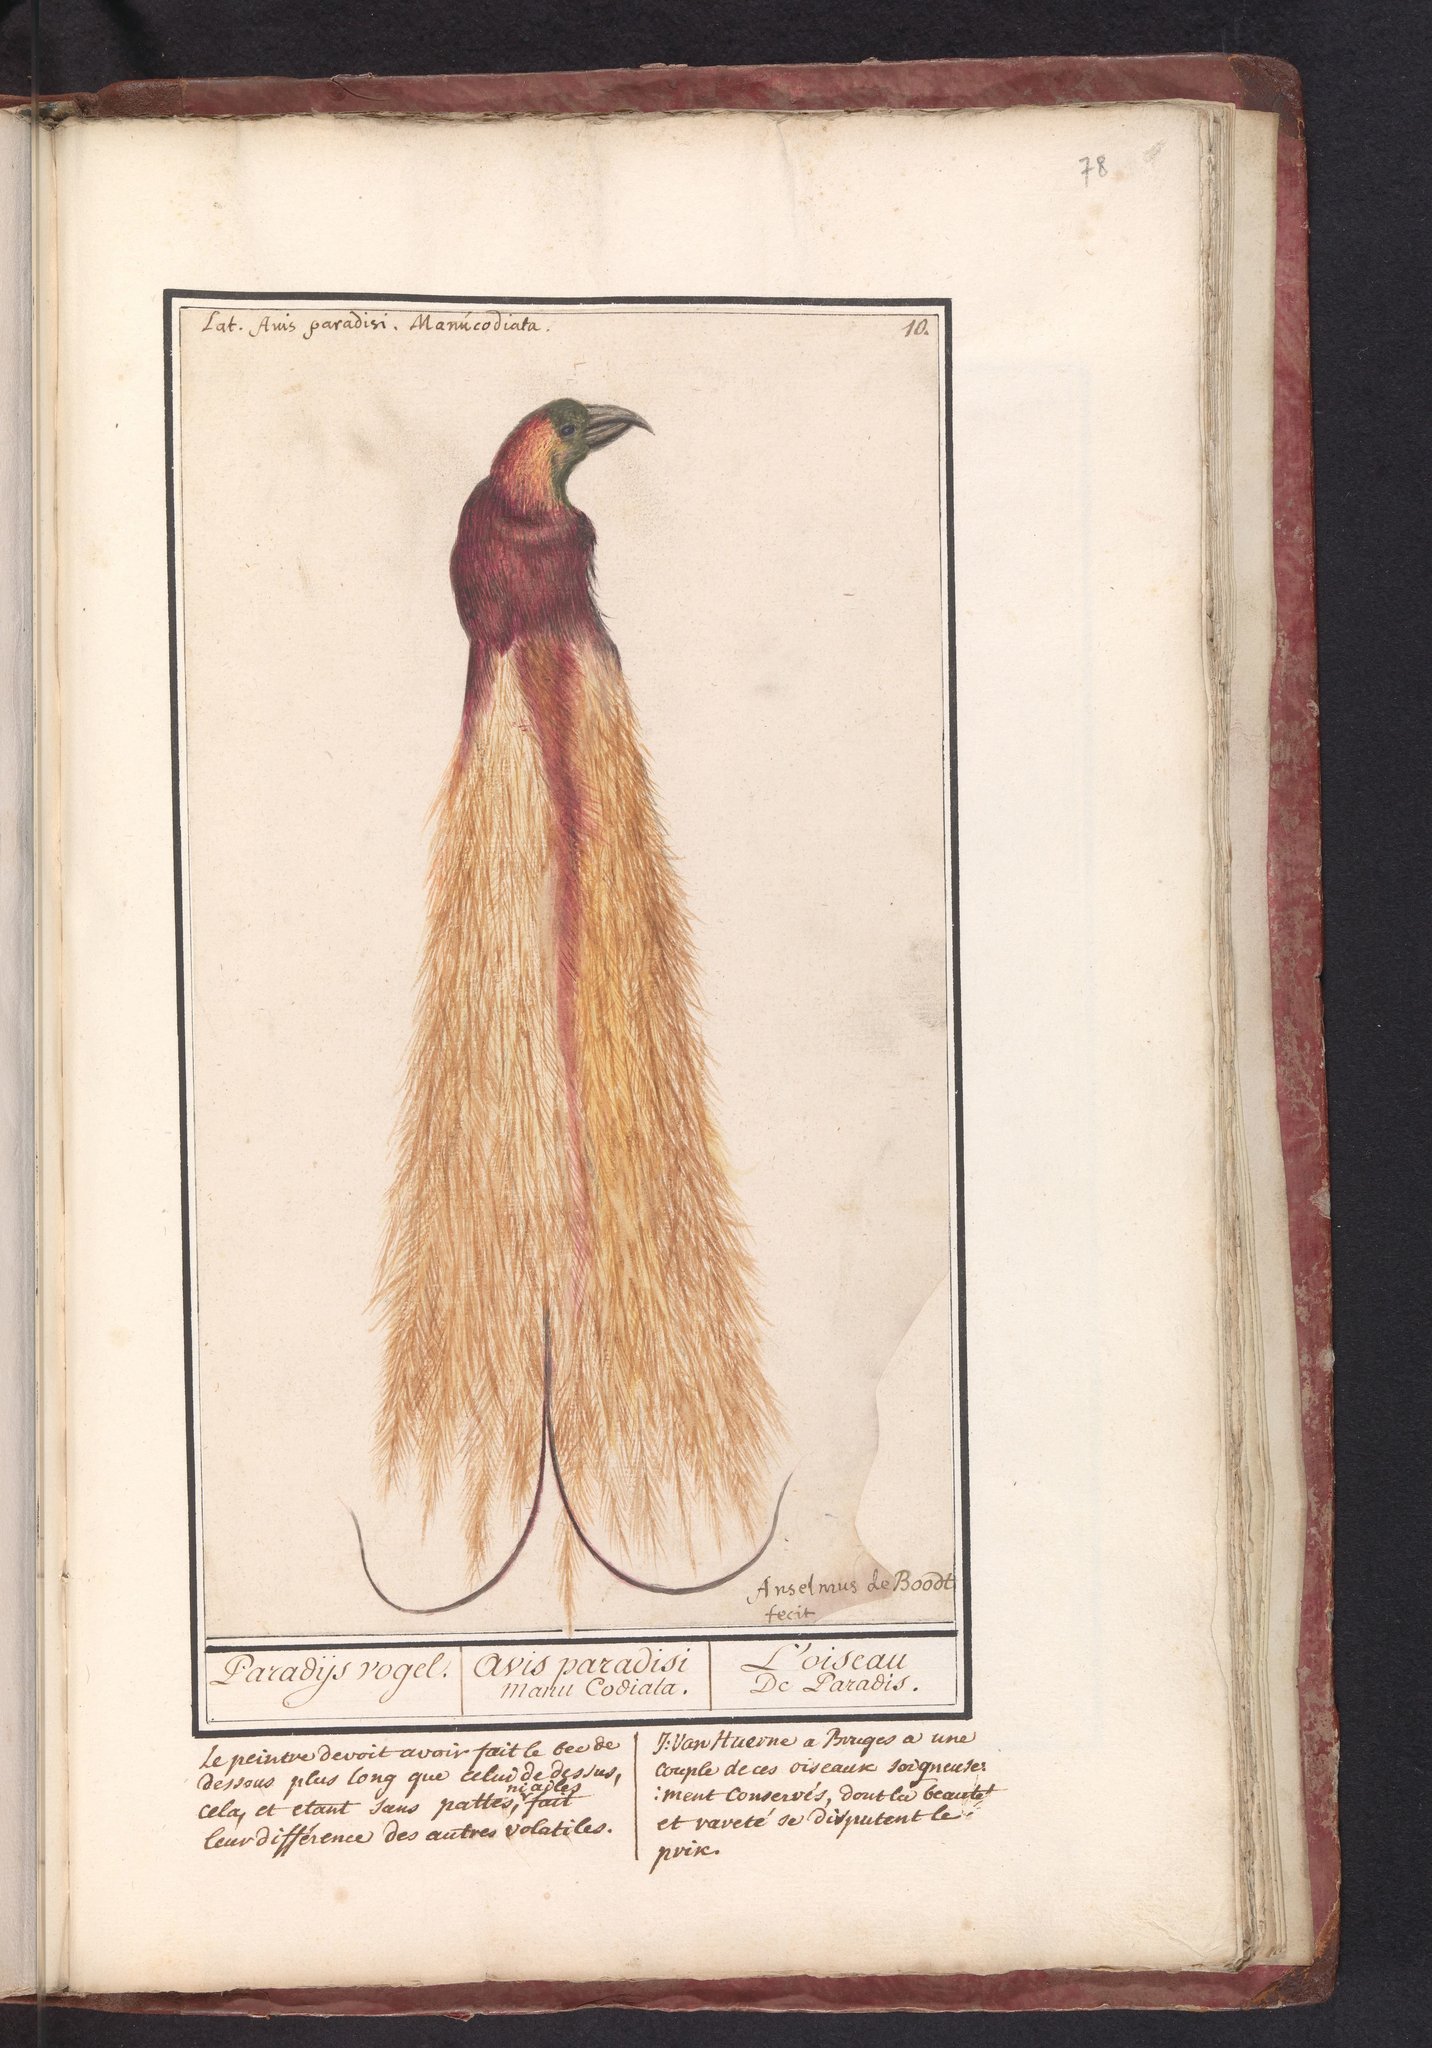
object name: drawing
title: Bird of paradise (Paradisaea apoda)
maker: anselmus boëtius de boodt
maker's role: draughtsman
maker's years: 1550-1632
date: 1596-1610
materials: paint, ink, paper, watercolor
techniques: brush, pen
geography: prague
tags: ornamental birds: greater bird-of-paradise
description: The myth that birds of paradise never had any feet and thus spent their life in perpetual flight goes back to ancient times. This draughtsman seems to have believed that as well. Even the 18th-century French inscription, sans pattes (without feet), emphasizes this apparent feature. In reality, the feet were removed by the local traders who sent the stuffed birds from Asia to Europe.